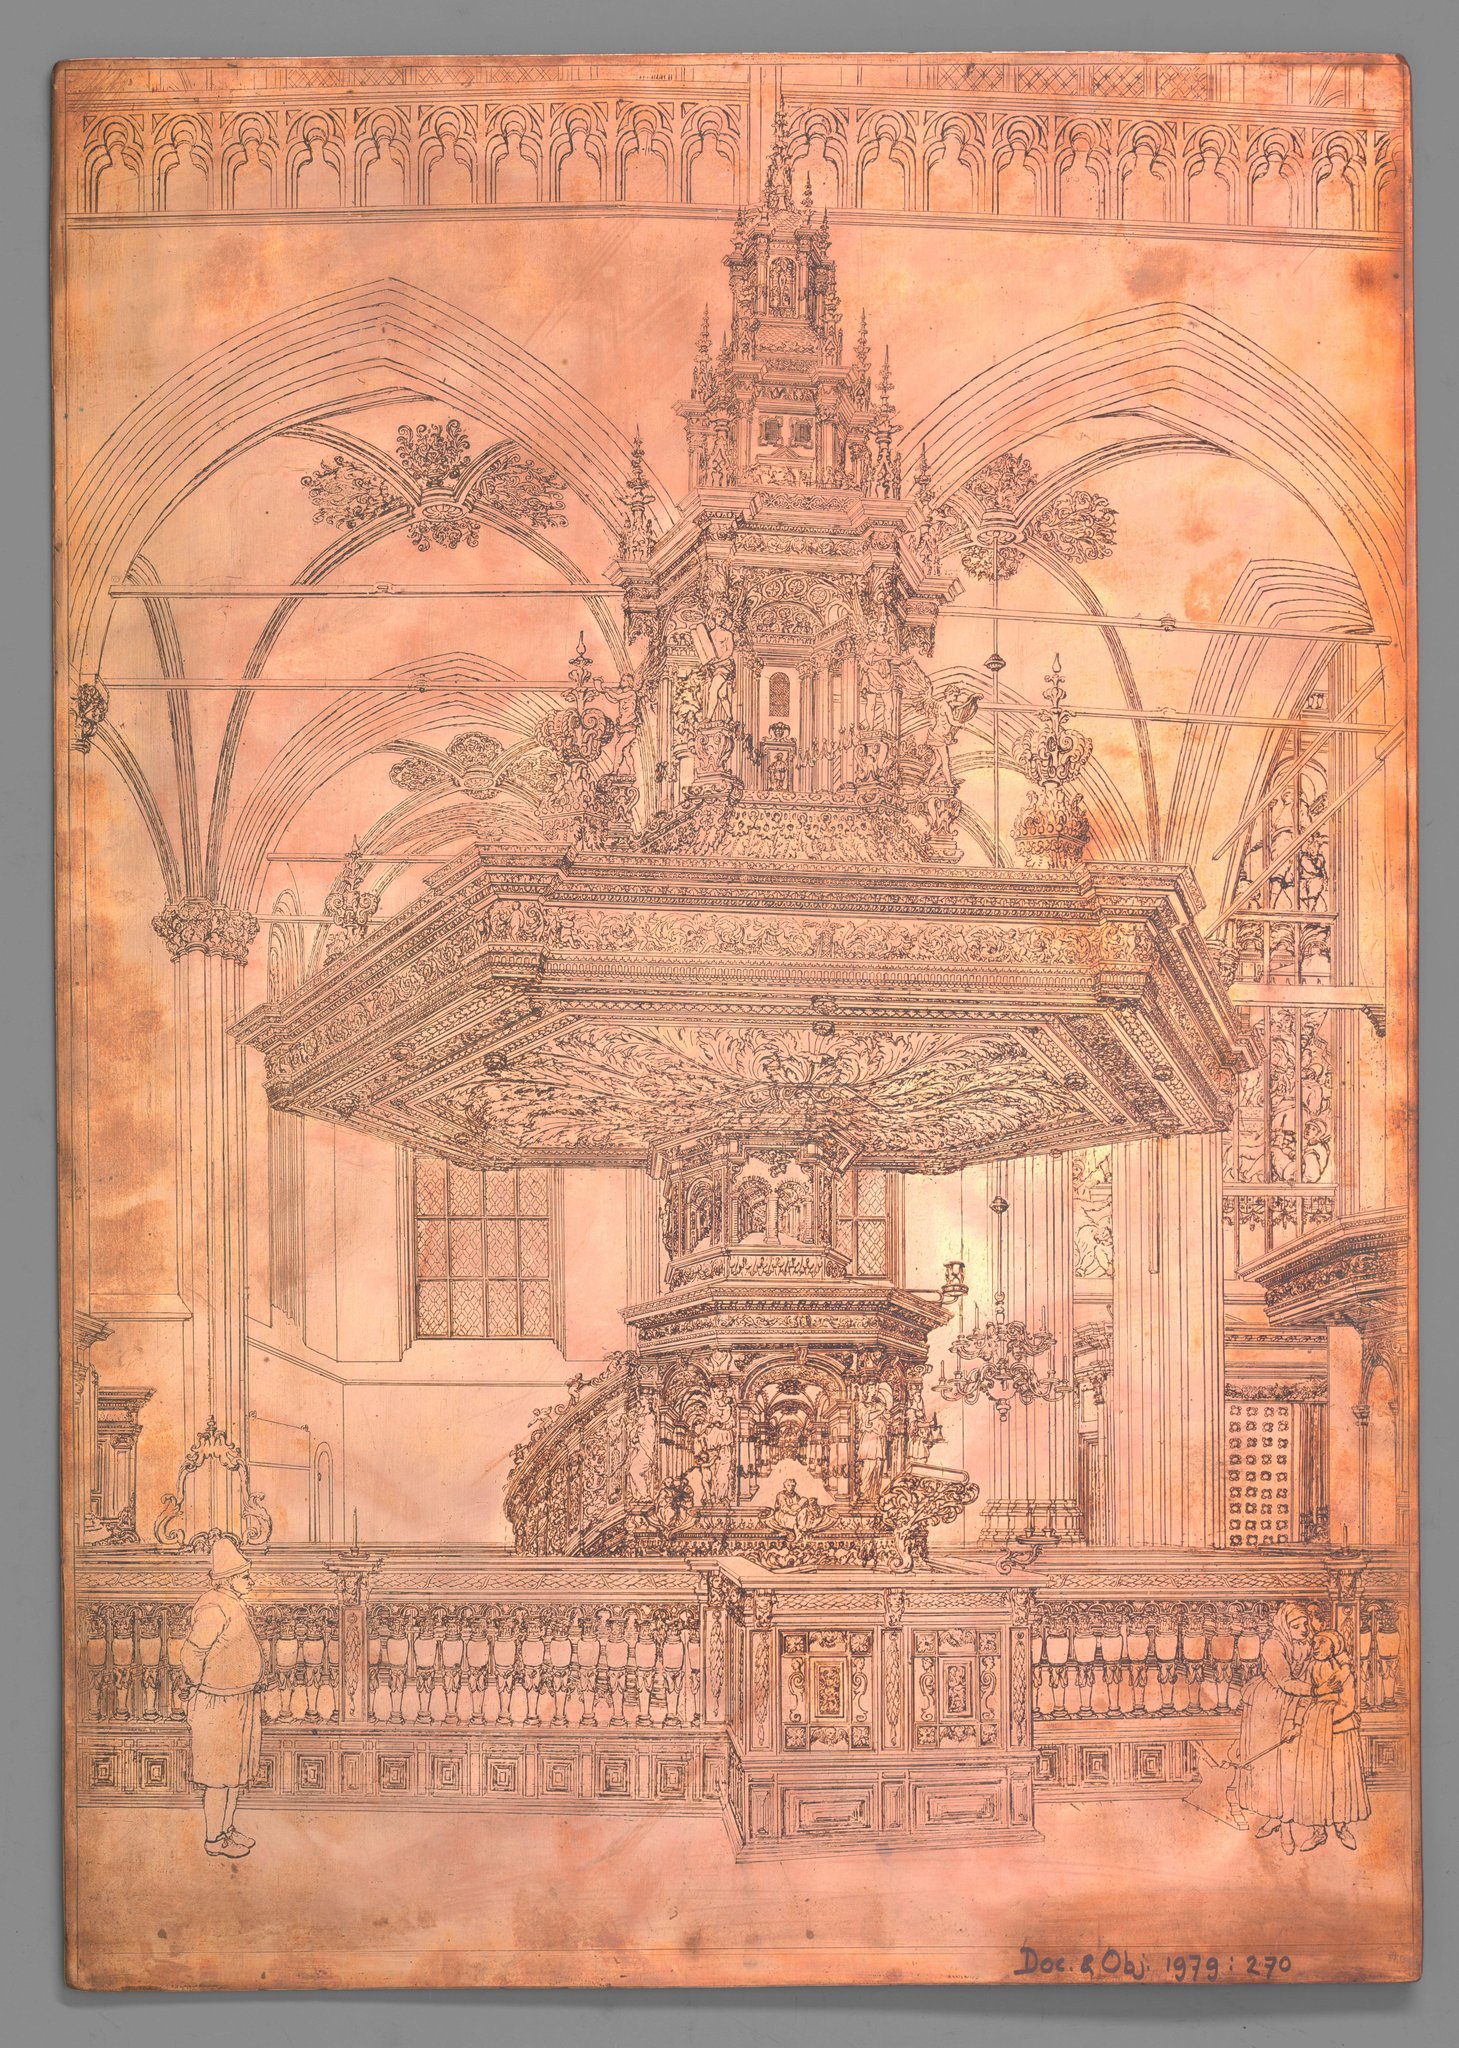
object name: copper plate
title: Preekstoel van Vinckenbrinck in de Nieuwe Kerk te Amsterdam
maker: pieter holsteyn (ii)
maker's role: draughtsman, print maker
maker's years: 1614-1673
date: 1649-1673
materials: copper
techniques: etching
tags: sculptor, albert jansz vinckenbrinck, interior of church, pulpit, ambo, chancel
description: Na de brand van 1645 kreeg beeldhouwer Albert Jansz. Vinckenbrinck opdracht voor het maken van een nieuwe preekstoel voor de Nieuwe Kerk. Bekend is dat hij van 1649 tot 1664 werkte aan deze preekstoel. In de collectie van het Stadsarchief Amsterdam bevindt tegendruk van deze ets die met zwarte inkt is ingekleurd en bijgewerkt. Op dit exemplaar staat linksonder 'J. v.d. Heyden, anno 1649' geschreven. De naam van Van der Heyden zorgt voor verwarring rondom het auteurschap van deze prent, die is geëtst door Pieter Holsteyn (II). Ook het jaartal 1649 is verwarrend, aangezien de preekstoel toen nog niet klaar was. Als het jaartal en de naam daadwerkelijk in 1649 op deze prent zijn geschreven is het aannemelijk dat een J. van der Heyden in 1649 zijn naam heeft gezet op een door hem ingekleurde tegendruk van de door Pieter Holsteyn (II) gemaakte prent. Dat dit al in 1649 was impliceert dat de prent is gemaakt naar een ontwerp van de preekstoel, die in de daaropvolgende jaren gerealiseerd zou worden.